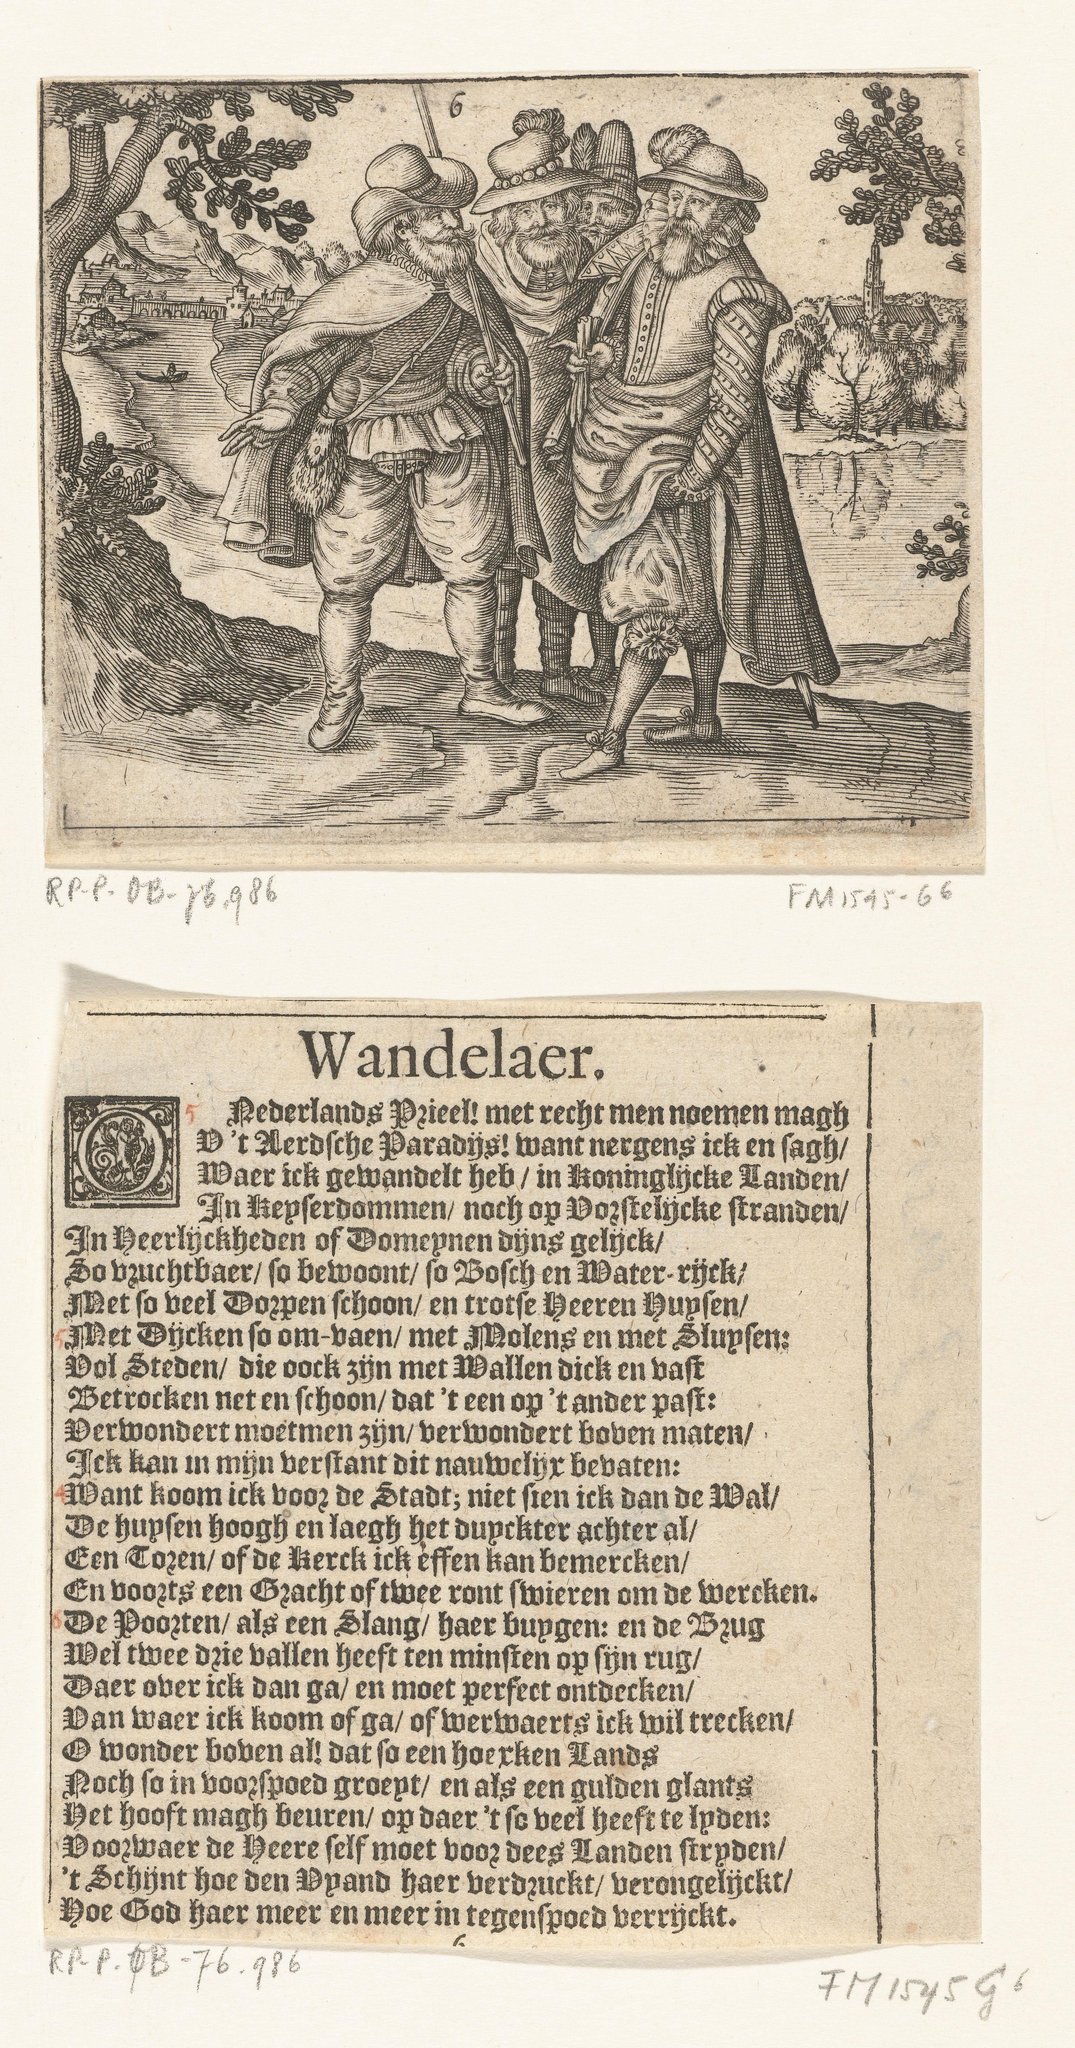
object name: print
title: Voorstellingen uit de Nederlandse maatschappij, ca. 1625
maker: Anonymous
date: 1620-1629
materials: paper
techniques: engraving, letterpress printing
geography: northern netherlands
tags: walking, hiking (recreation)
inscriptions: caption: ‘Wandelaer: O Nederlands Prieel! Met recht men noemen magh/ 't aerdsche Paradijs ! Want nergens ick en sagh / Waer ick gewandelt heb / in koninklijcke Landen....In Heerlijckheden of Domeynen sijns gelijck / so vruchtbaer,/ so bewoont / so Bosch en Water-rijck....’, number: ‘6’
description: Een groep van vier wandelaars staande bij elkaar in een landschap, op de achtergrond een rivier. Onderdeel van een serie voorstellingen van de Nederlandse maatschappij, ca. 1625. De prent met het bijbehorende vers op een apart blad.